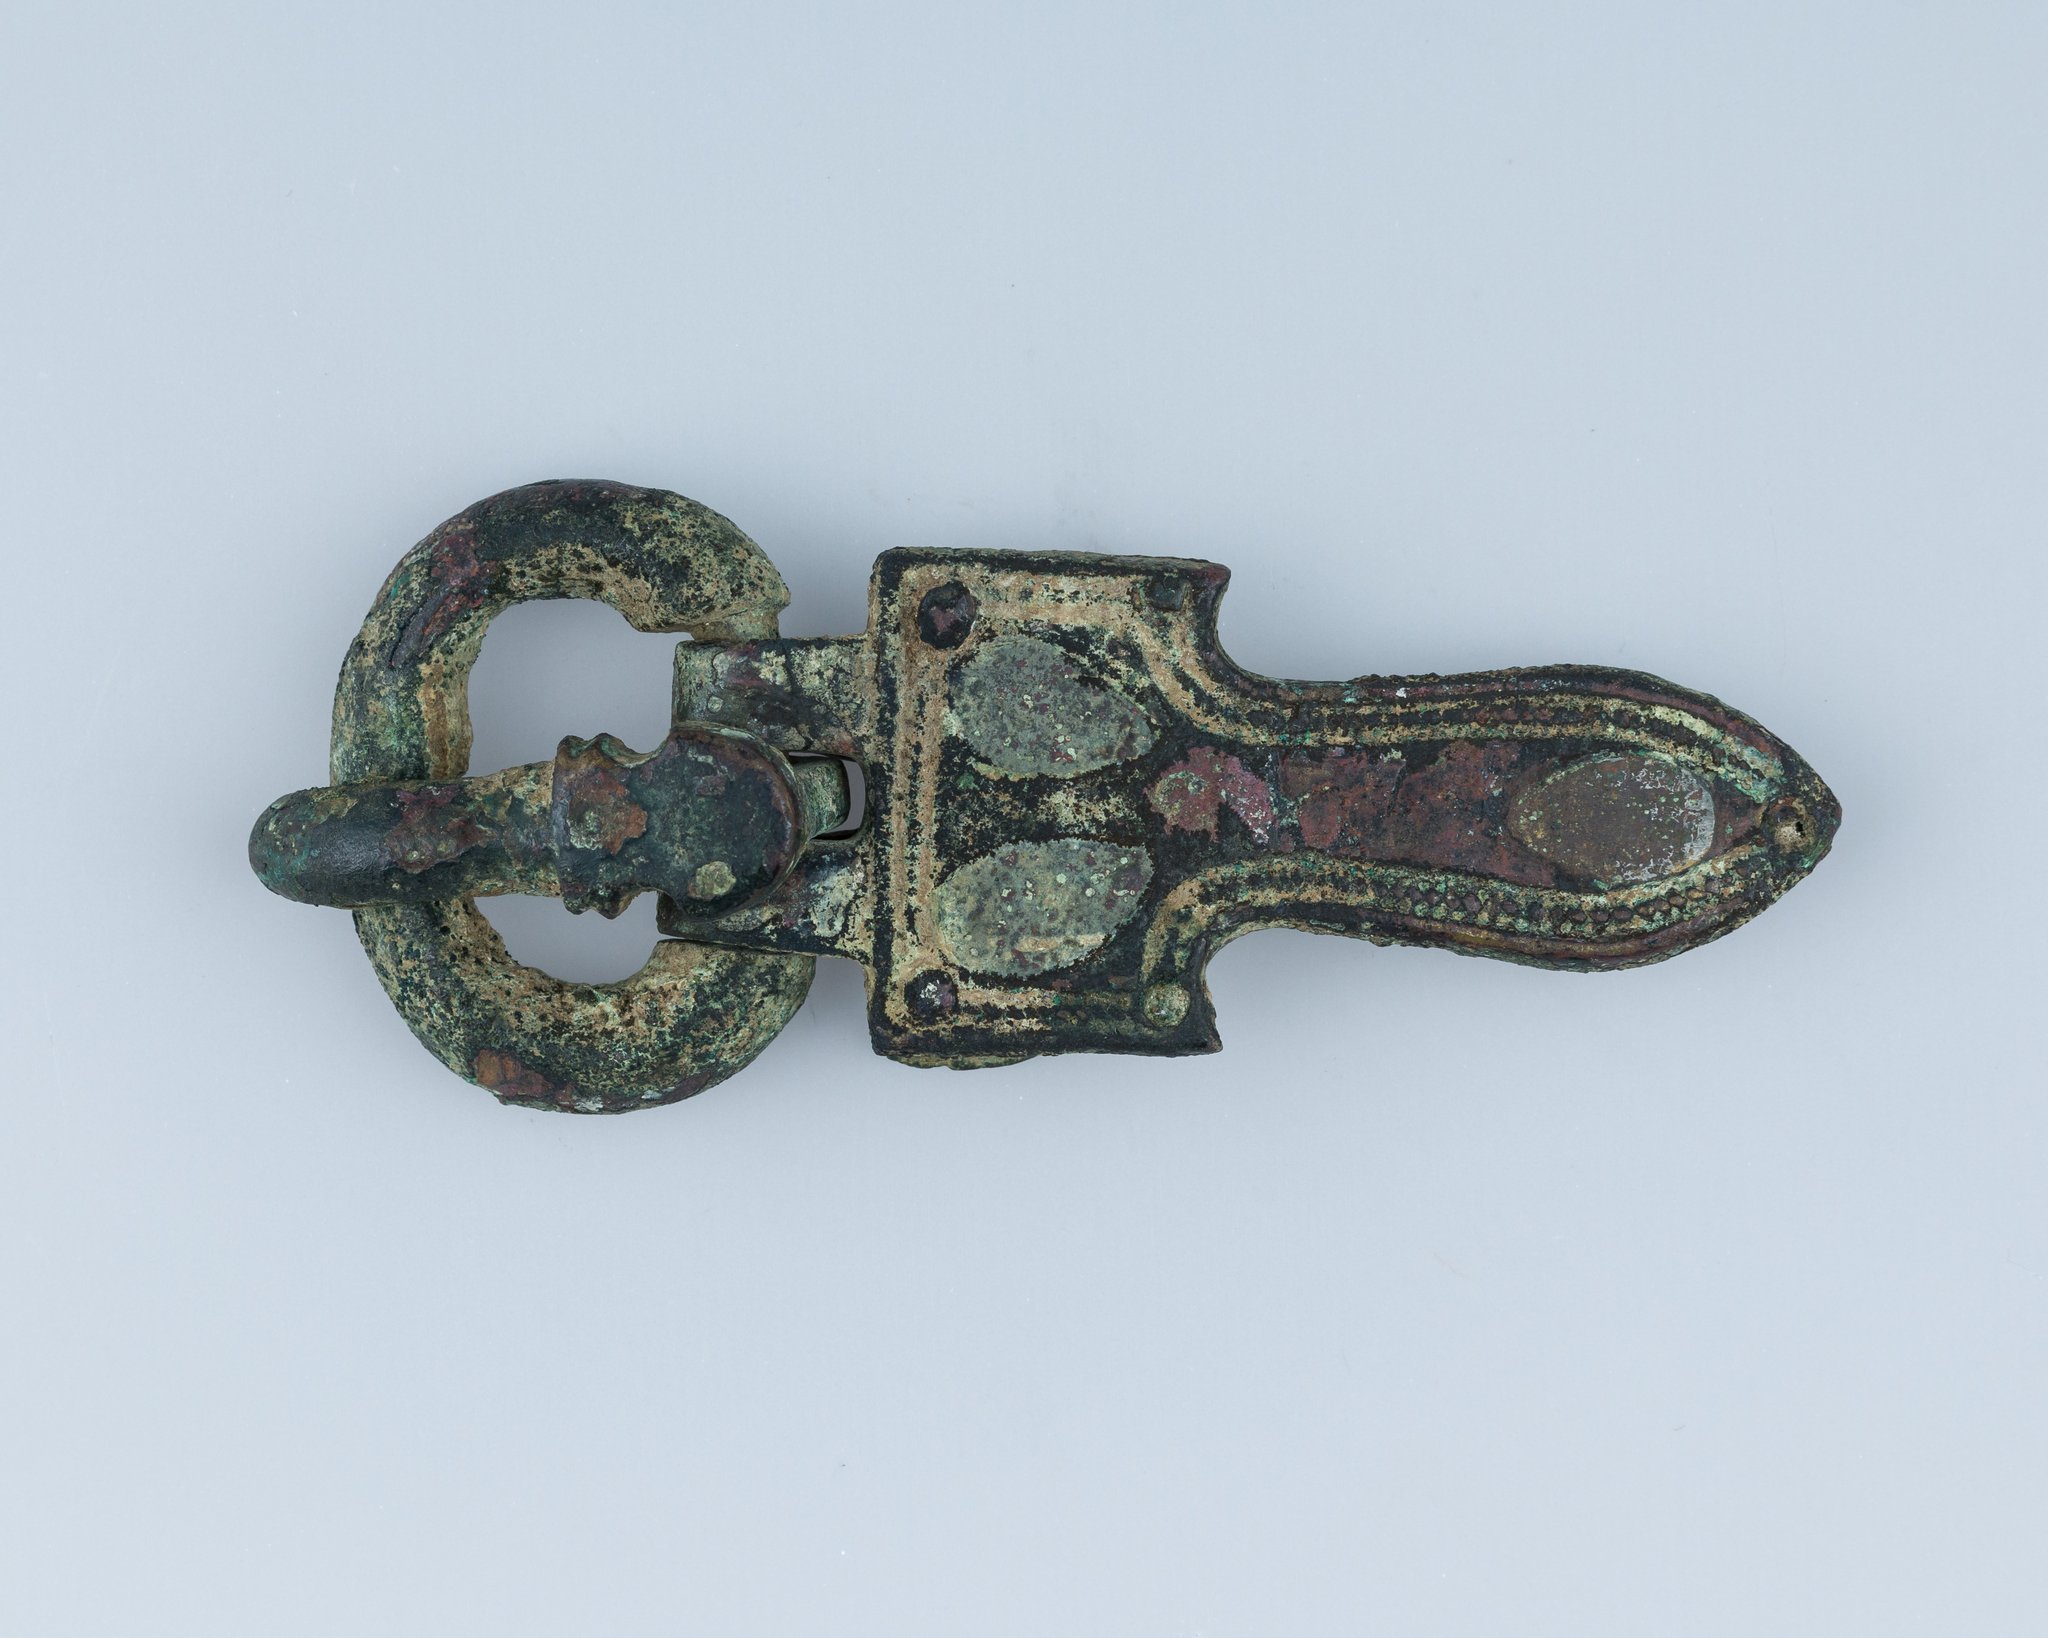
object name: buckle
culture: ibero-roman or visigothic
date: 409-711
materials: bronze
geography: spain